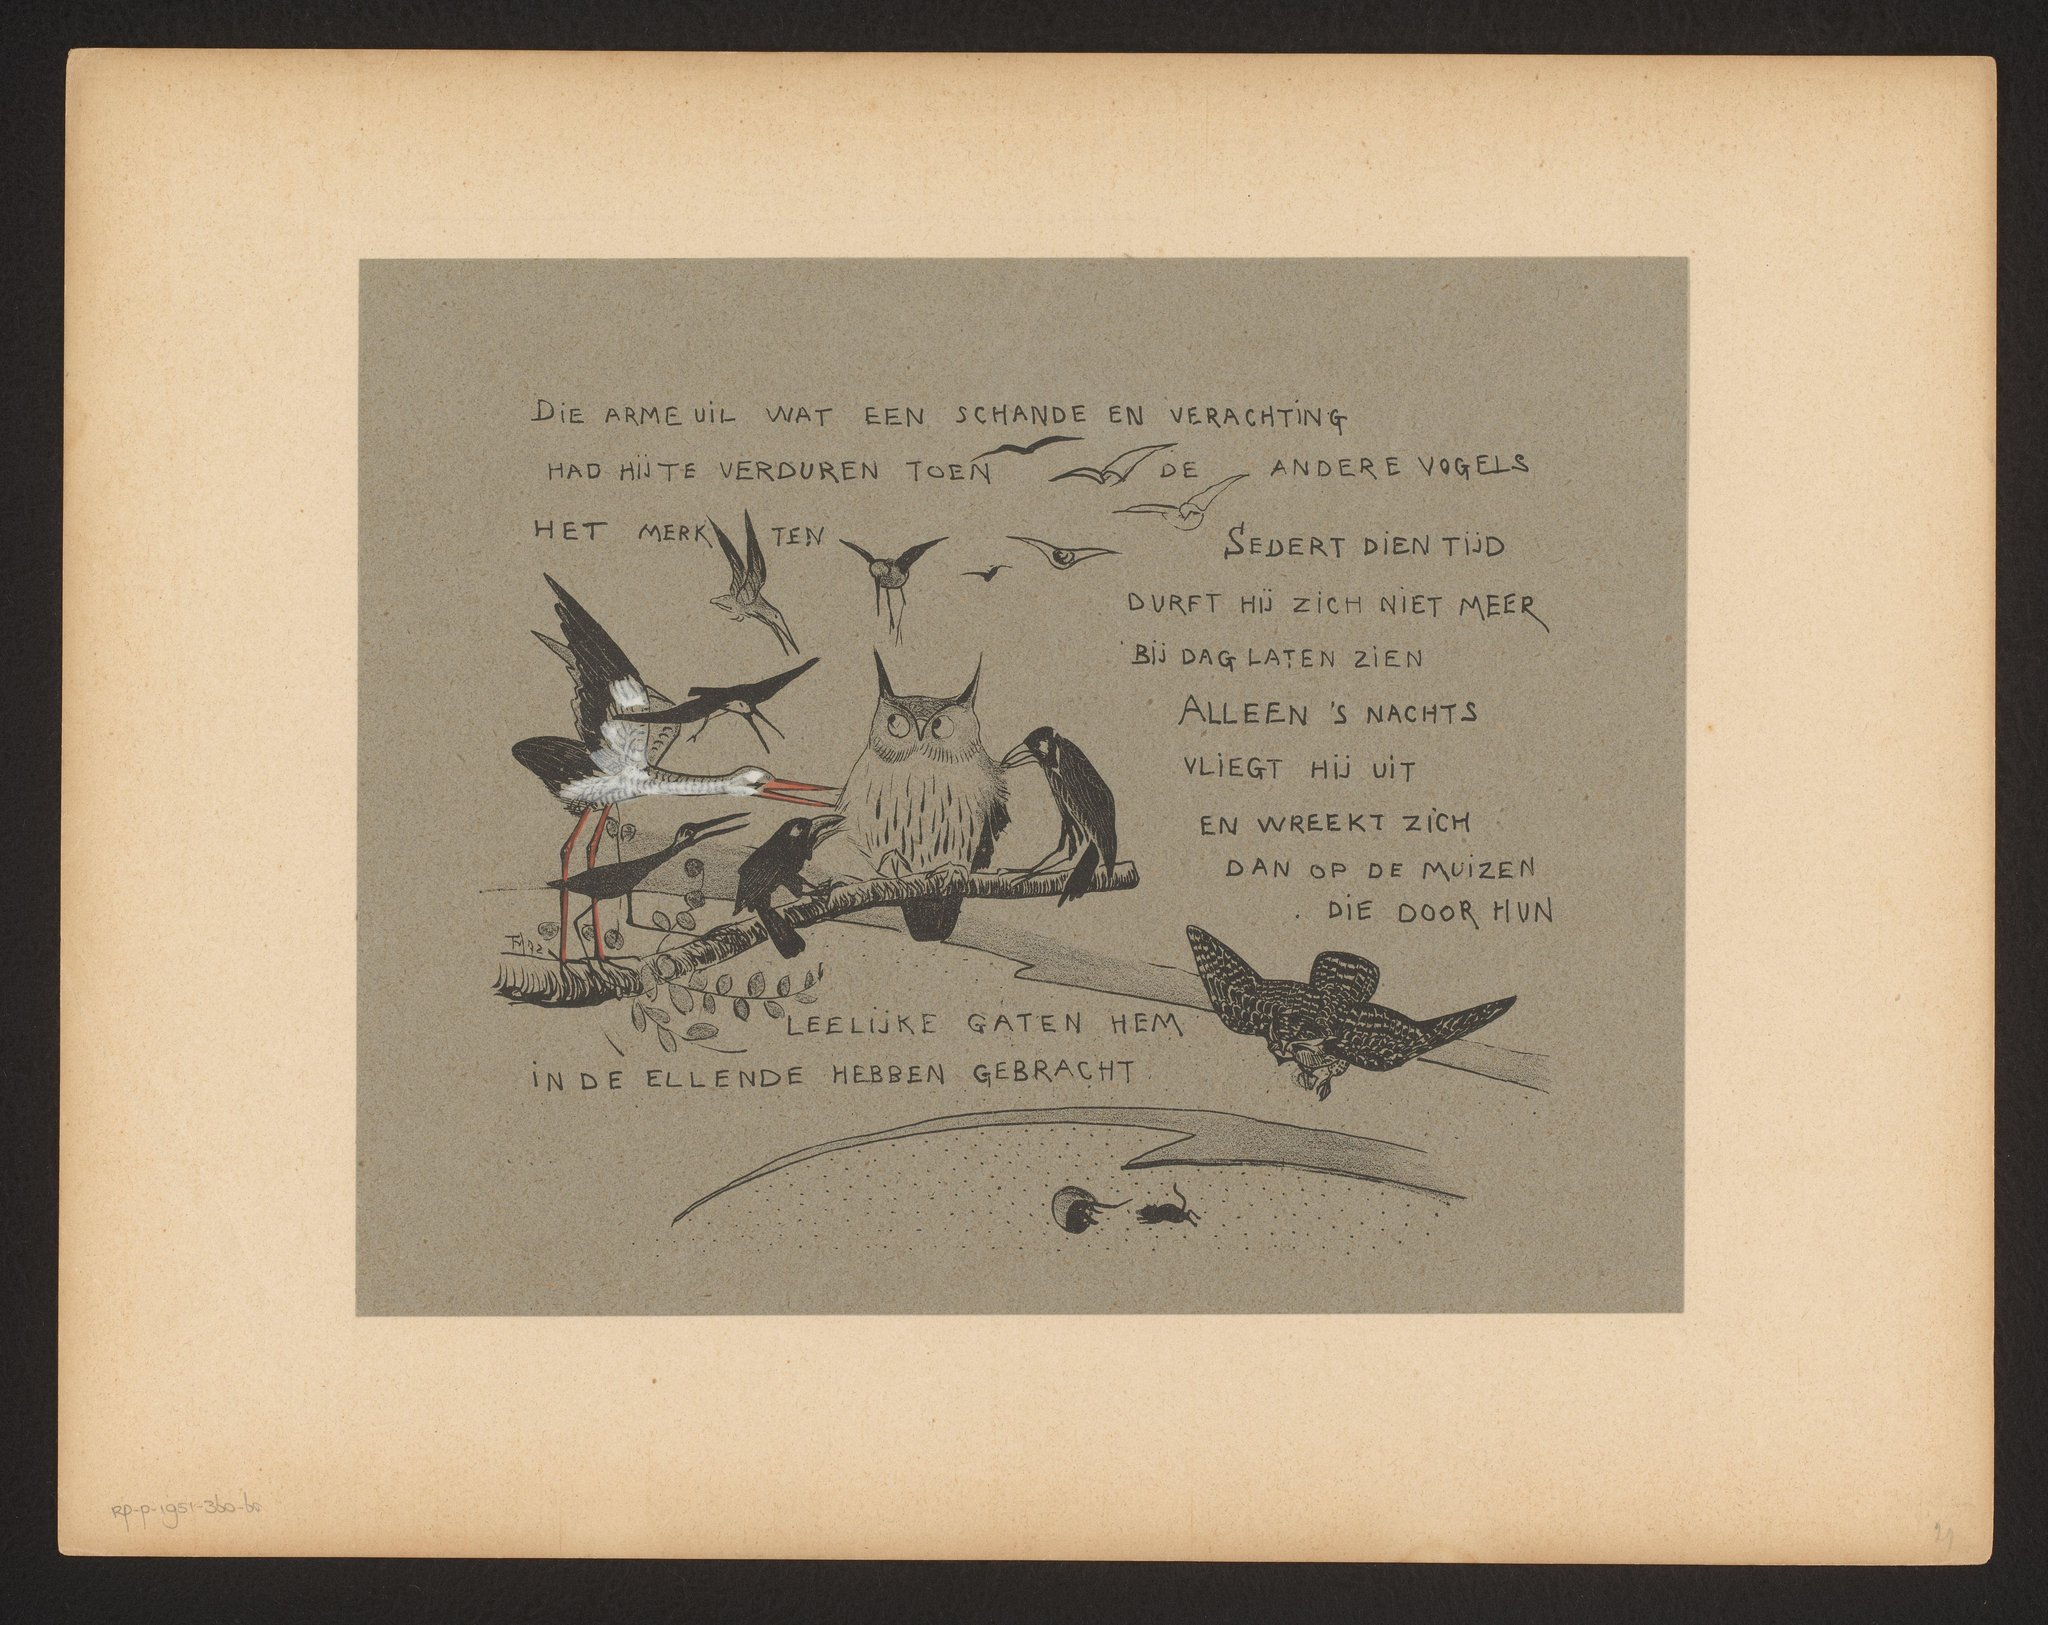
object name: print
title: Tekstblad met vogels die de uil terechtwijzen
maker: theo van hoytema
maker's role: draughtsman, painter, print maker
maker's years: 1863-1917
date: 1892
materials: paper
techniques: hand coloring, lithograph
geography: the hague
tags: groups of birds, owls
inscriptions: date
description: Zowel tekst als afbeelding zijn gelithografeerd.